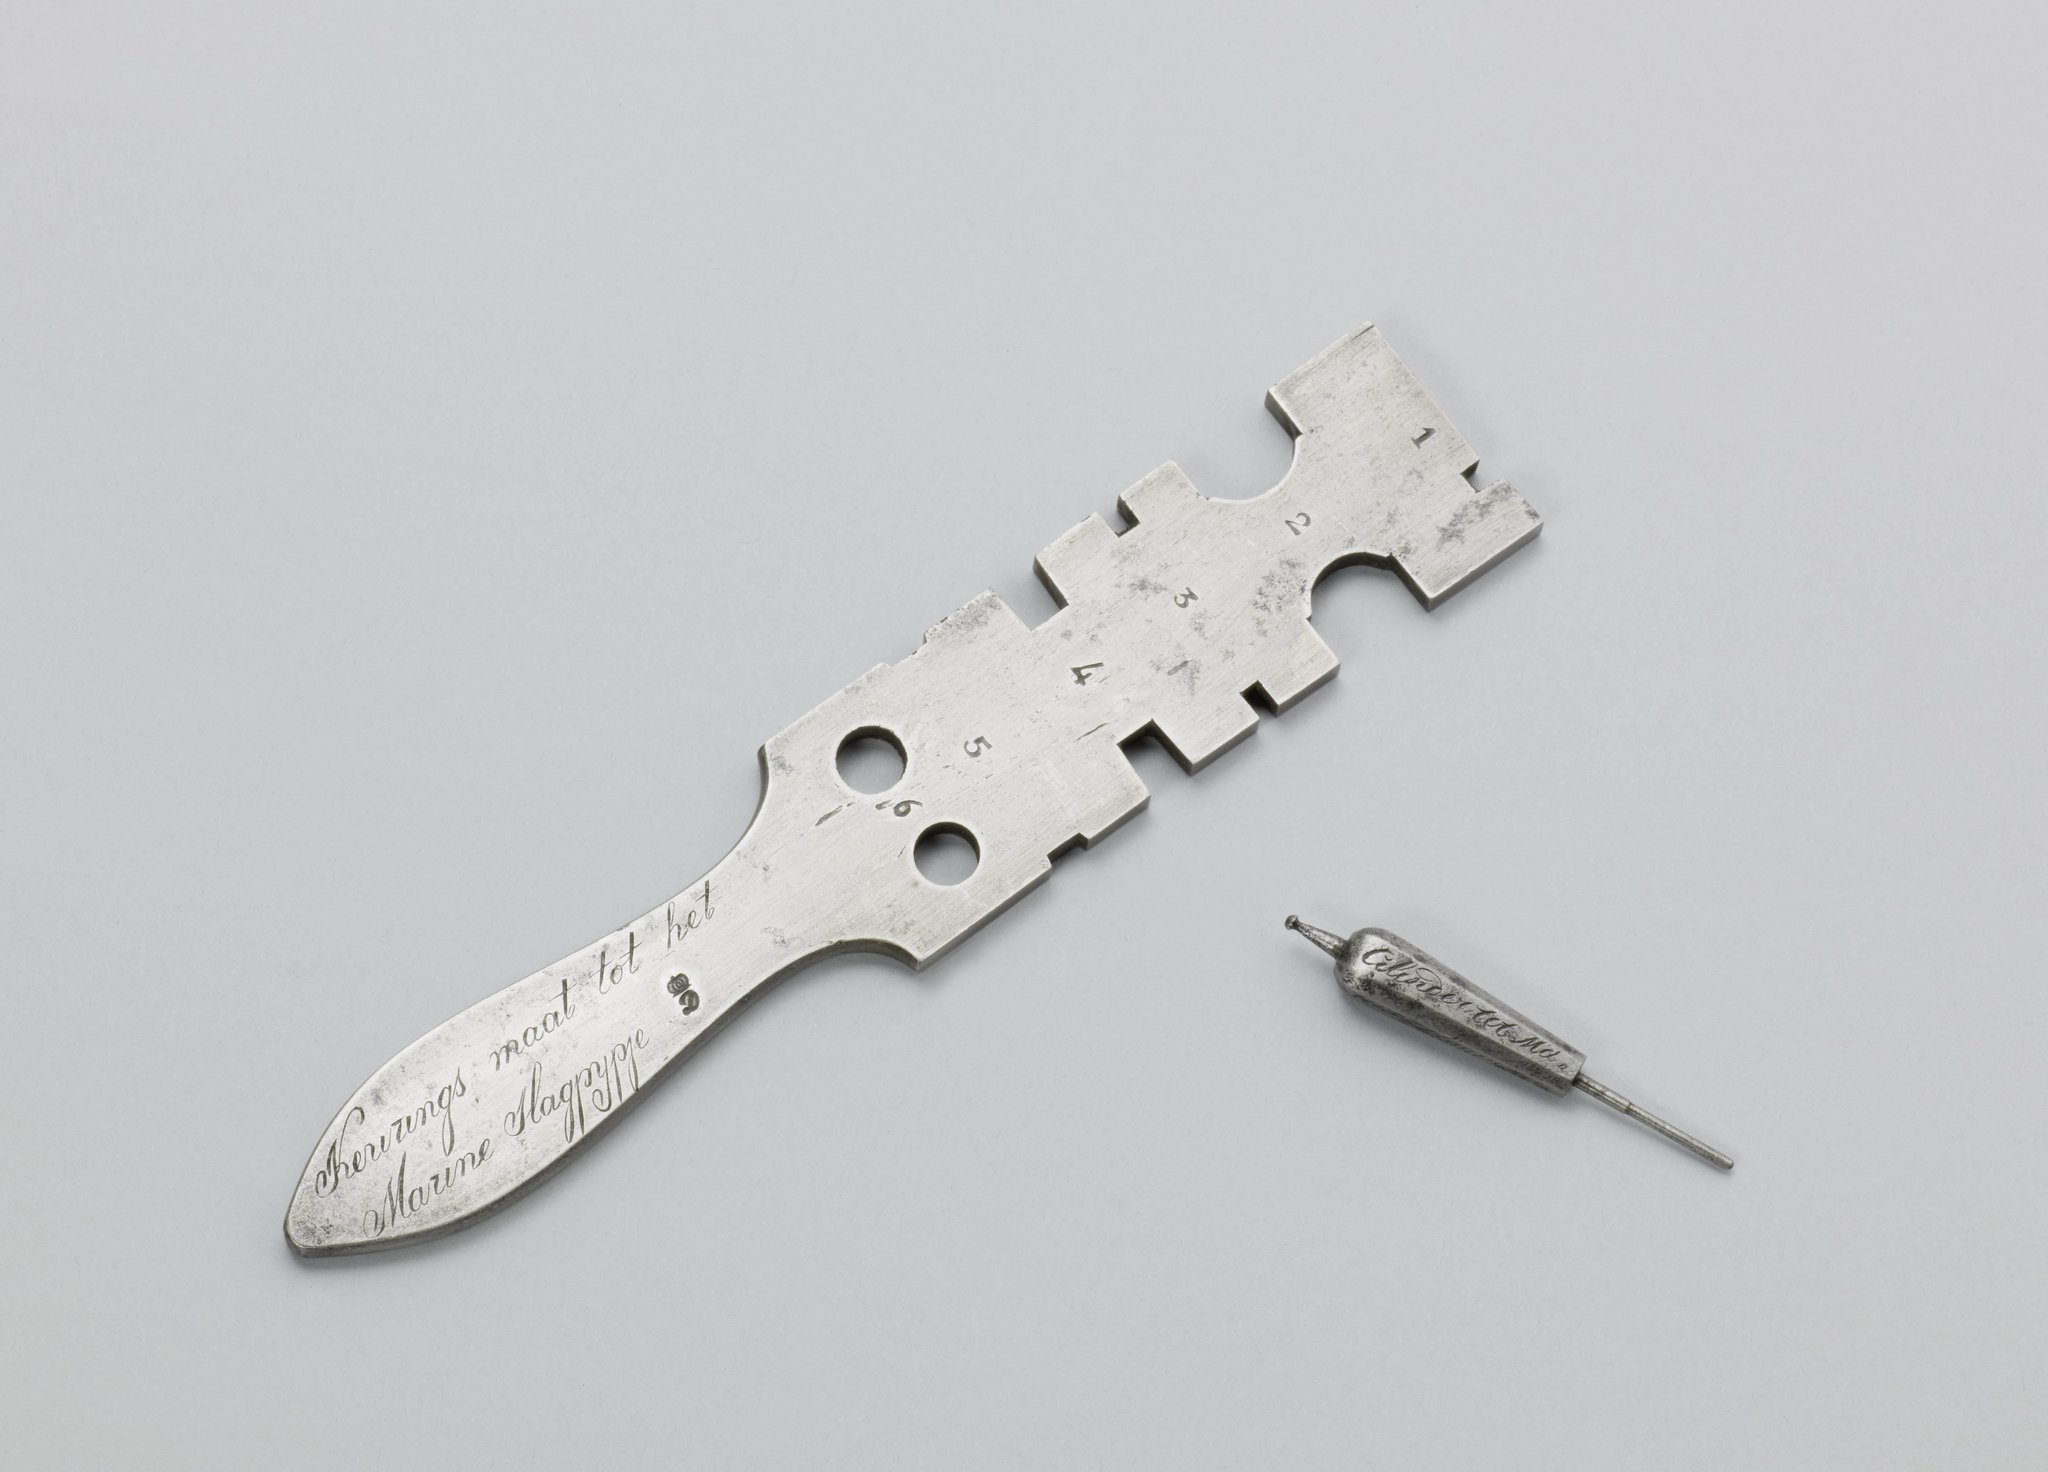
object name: mould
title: Gauge for Priming Tubes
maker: Anonymous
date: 1847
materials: iron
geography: netherlands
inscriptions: inscription, on the small handle: ‘Cilinder tot Md’’, inscription, on the handle of the gauge: ‘Keurings maat tot het / Marine slagpijpje’, monogram, on the handle of the gauge: crowned D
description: Deze mal, mal NG-MC-1054-B (genummerd 8 en 9), samen met een derde genummerd 7, die verloren is, werden gebruikt om de slagpijpjes op te meten. De afmetingen van deze mallen, en ander gereedschap, werden vastgelegd in 1847 en in 1849 werden deze bepalingen gedrukt.